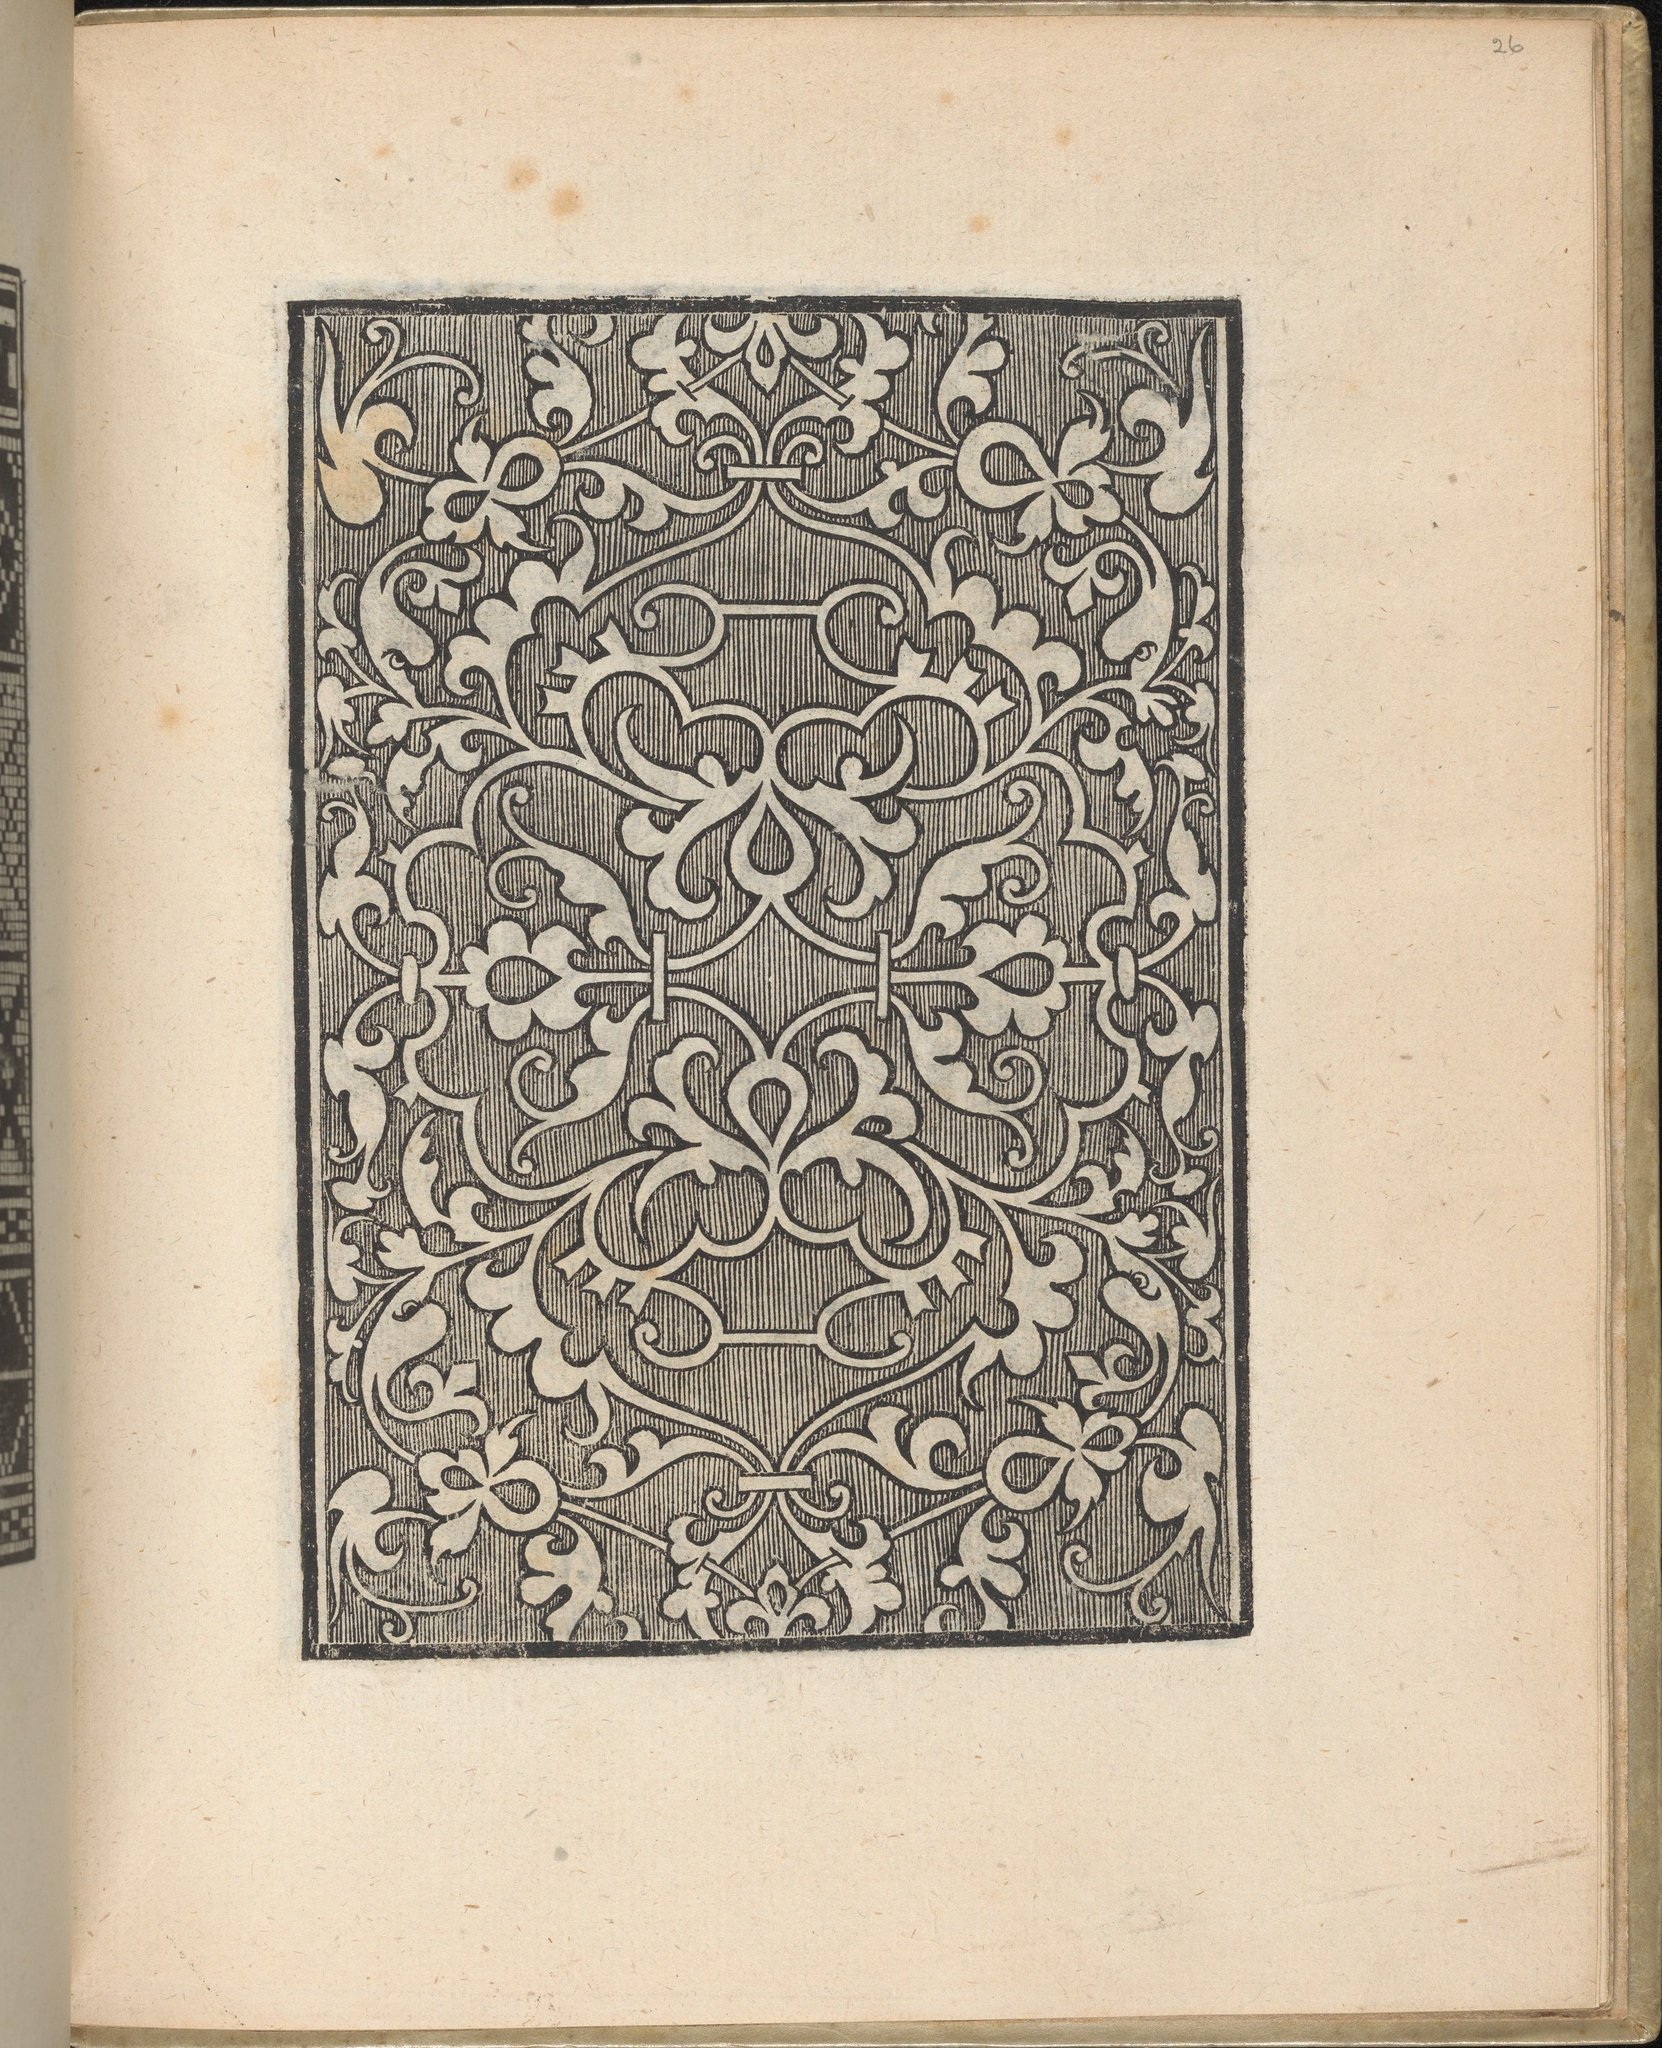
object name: book print ornament architecture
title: Trionfo Di Virtu. Libro Novo..., page 26 (verso)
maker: matteo pagano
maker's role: publisher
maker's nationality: italian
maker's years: 1515-1588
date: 1563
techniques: woodcut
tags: ornament